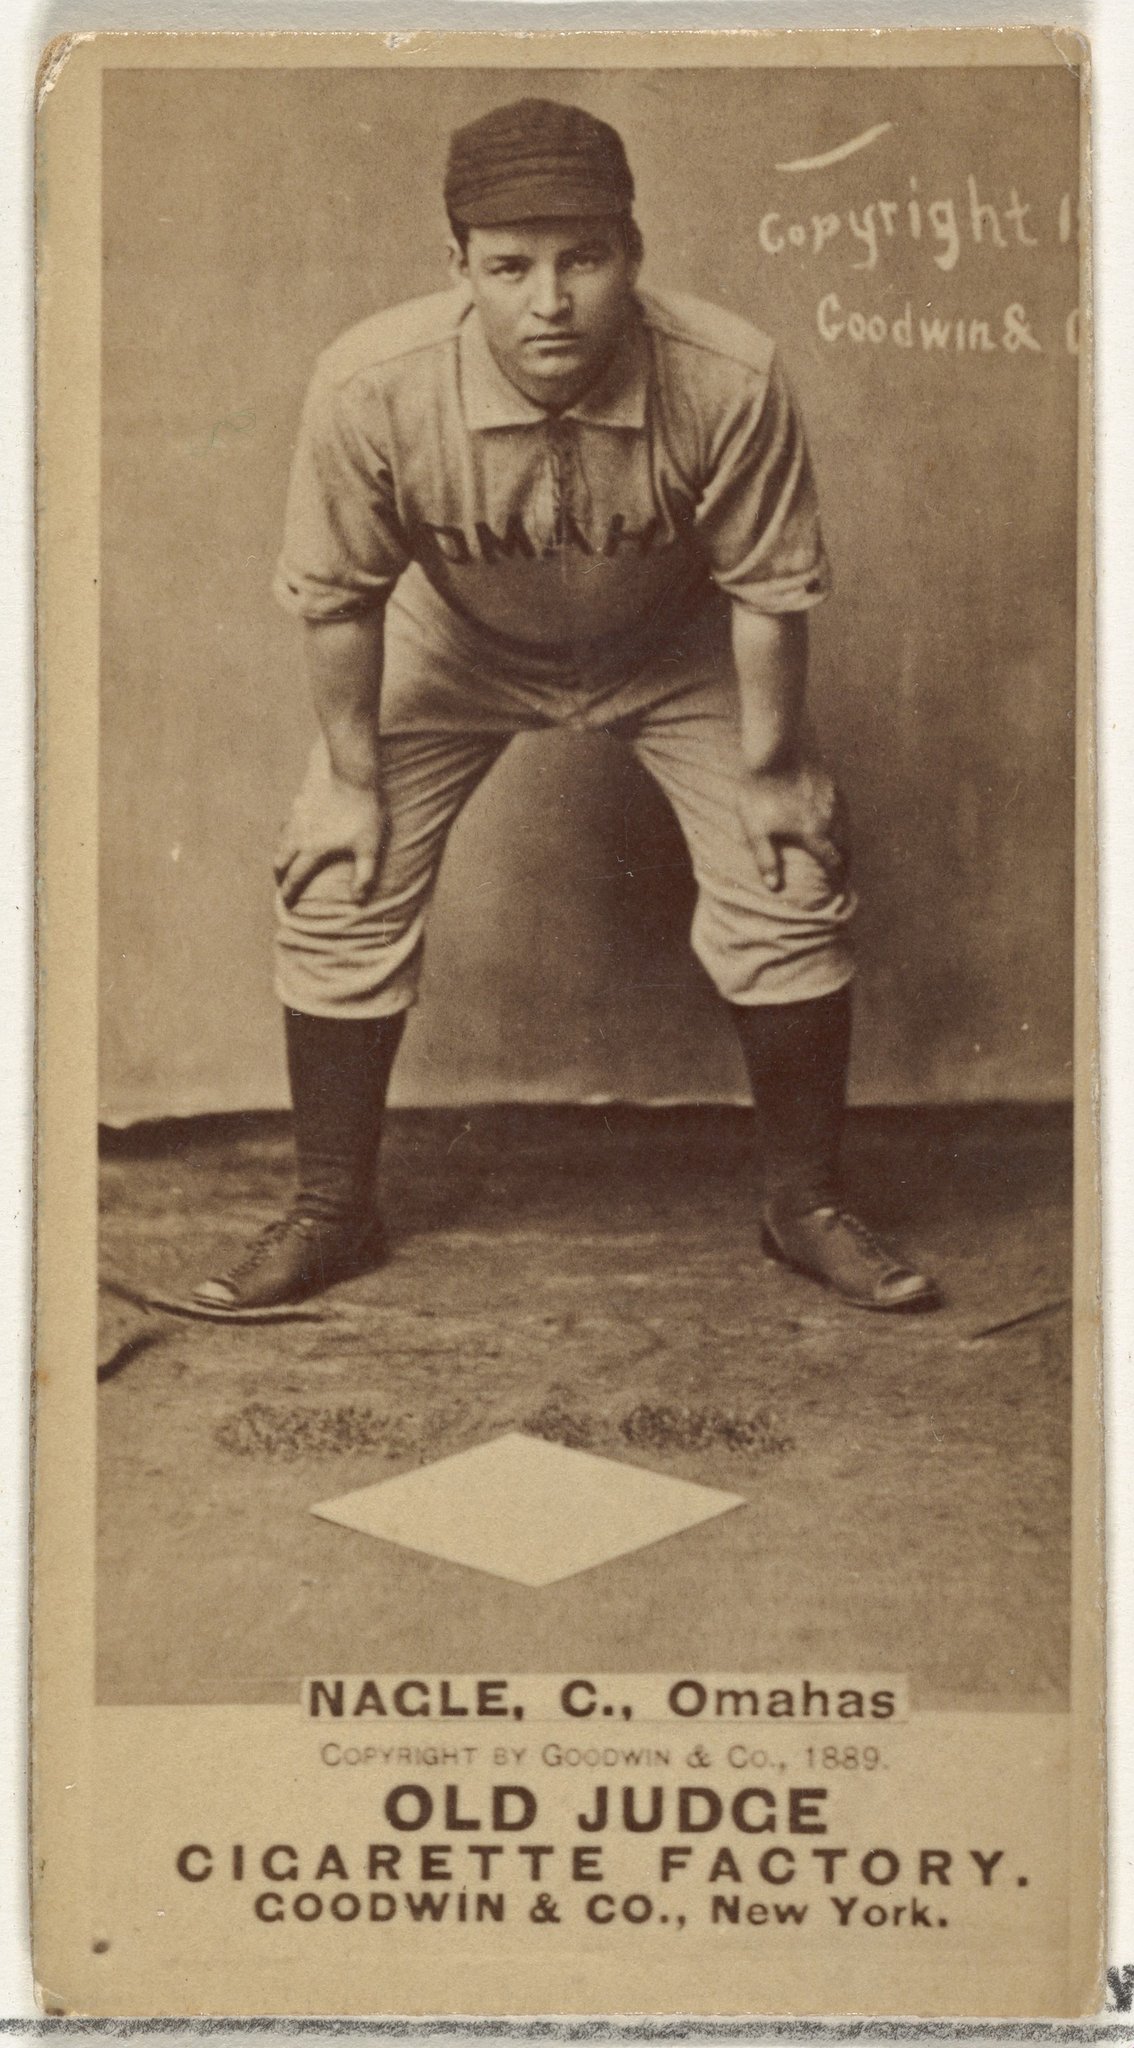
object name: baseball card, photograph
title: Nagle, Catcher, Omaha Omahogs/ Lambs, from the Old Judge series (N172) for Old Judge Cigarettes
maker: goodwin & company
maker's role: publisher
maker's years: 1850-1950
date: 1889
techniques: albumen silver print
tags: men,portraits,baseball,athletes